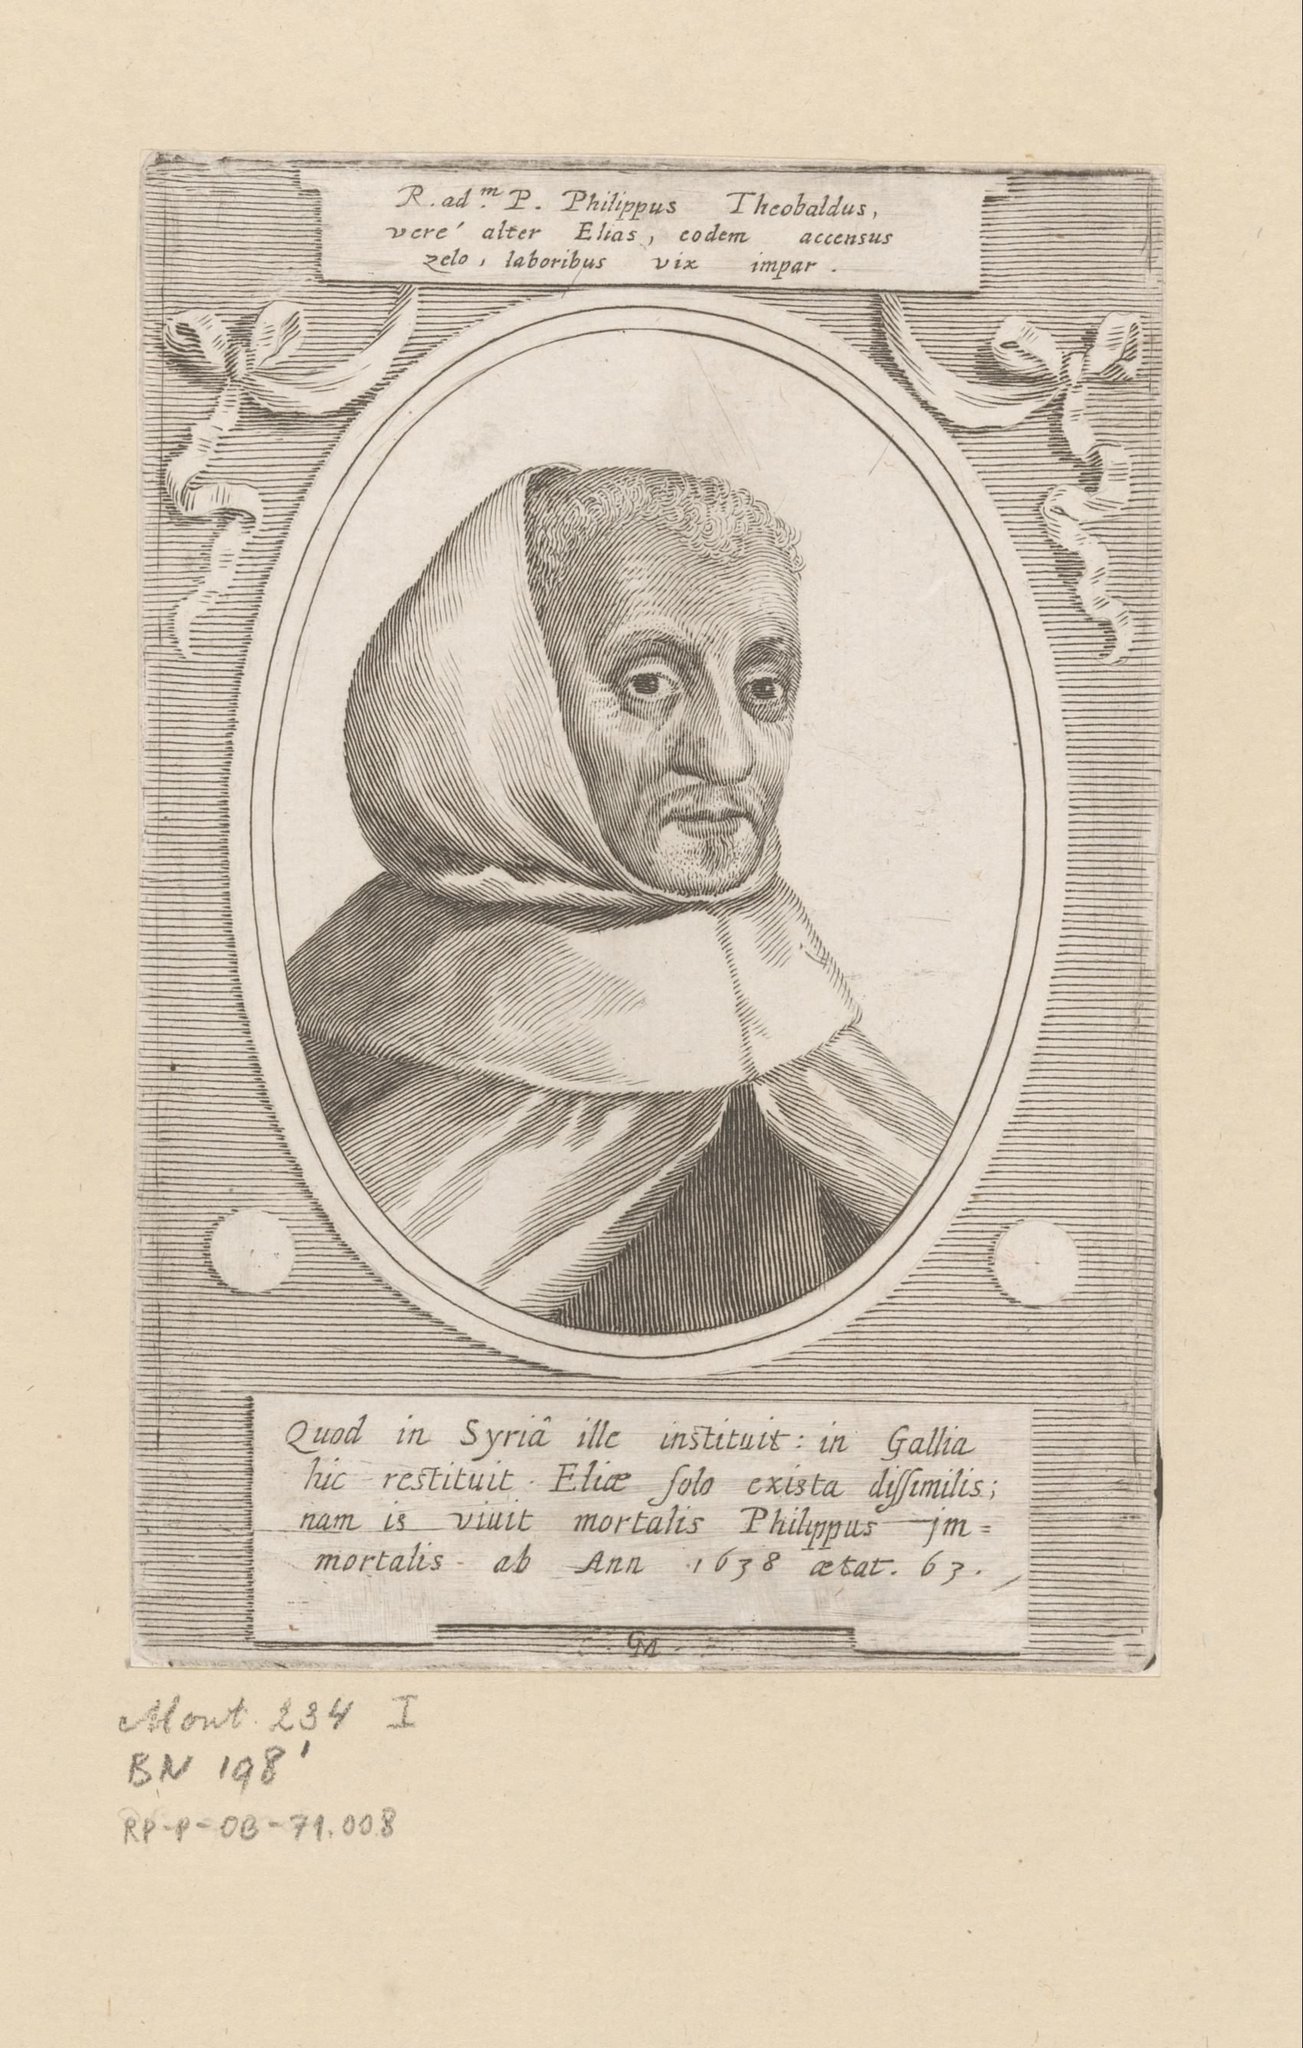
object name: print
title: Portret van Philippe Thibault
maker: claude mellan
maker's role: draughtsman, print maker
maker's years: 1598-1688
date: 1638-1688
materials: paper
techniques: engraving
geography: france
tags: historical persons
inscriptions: collector's mark: Lugt 240